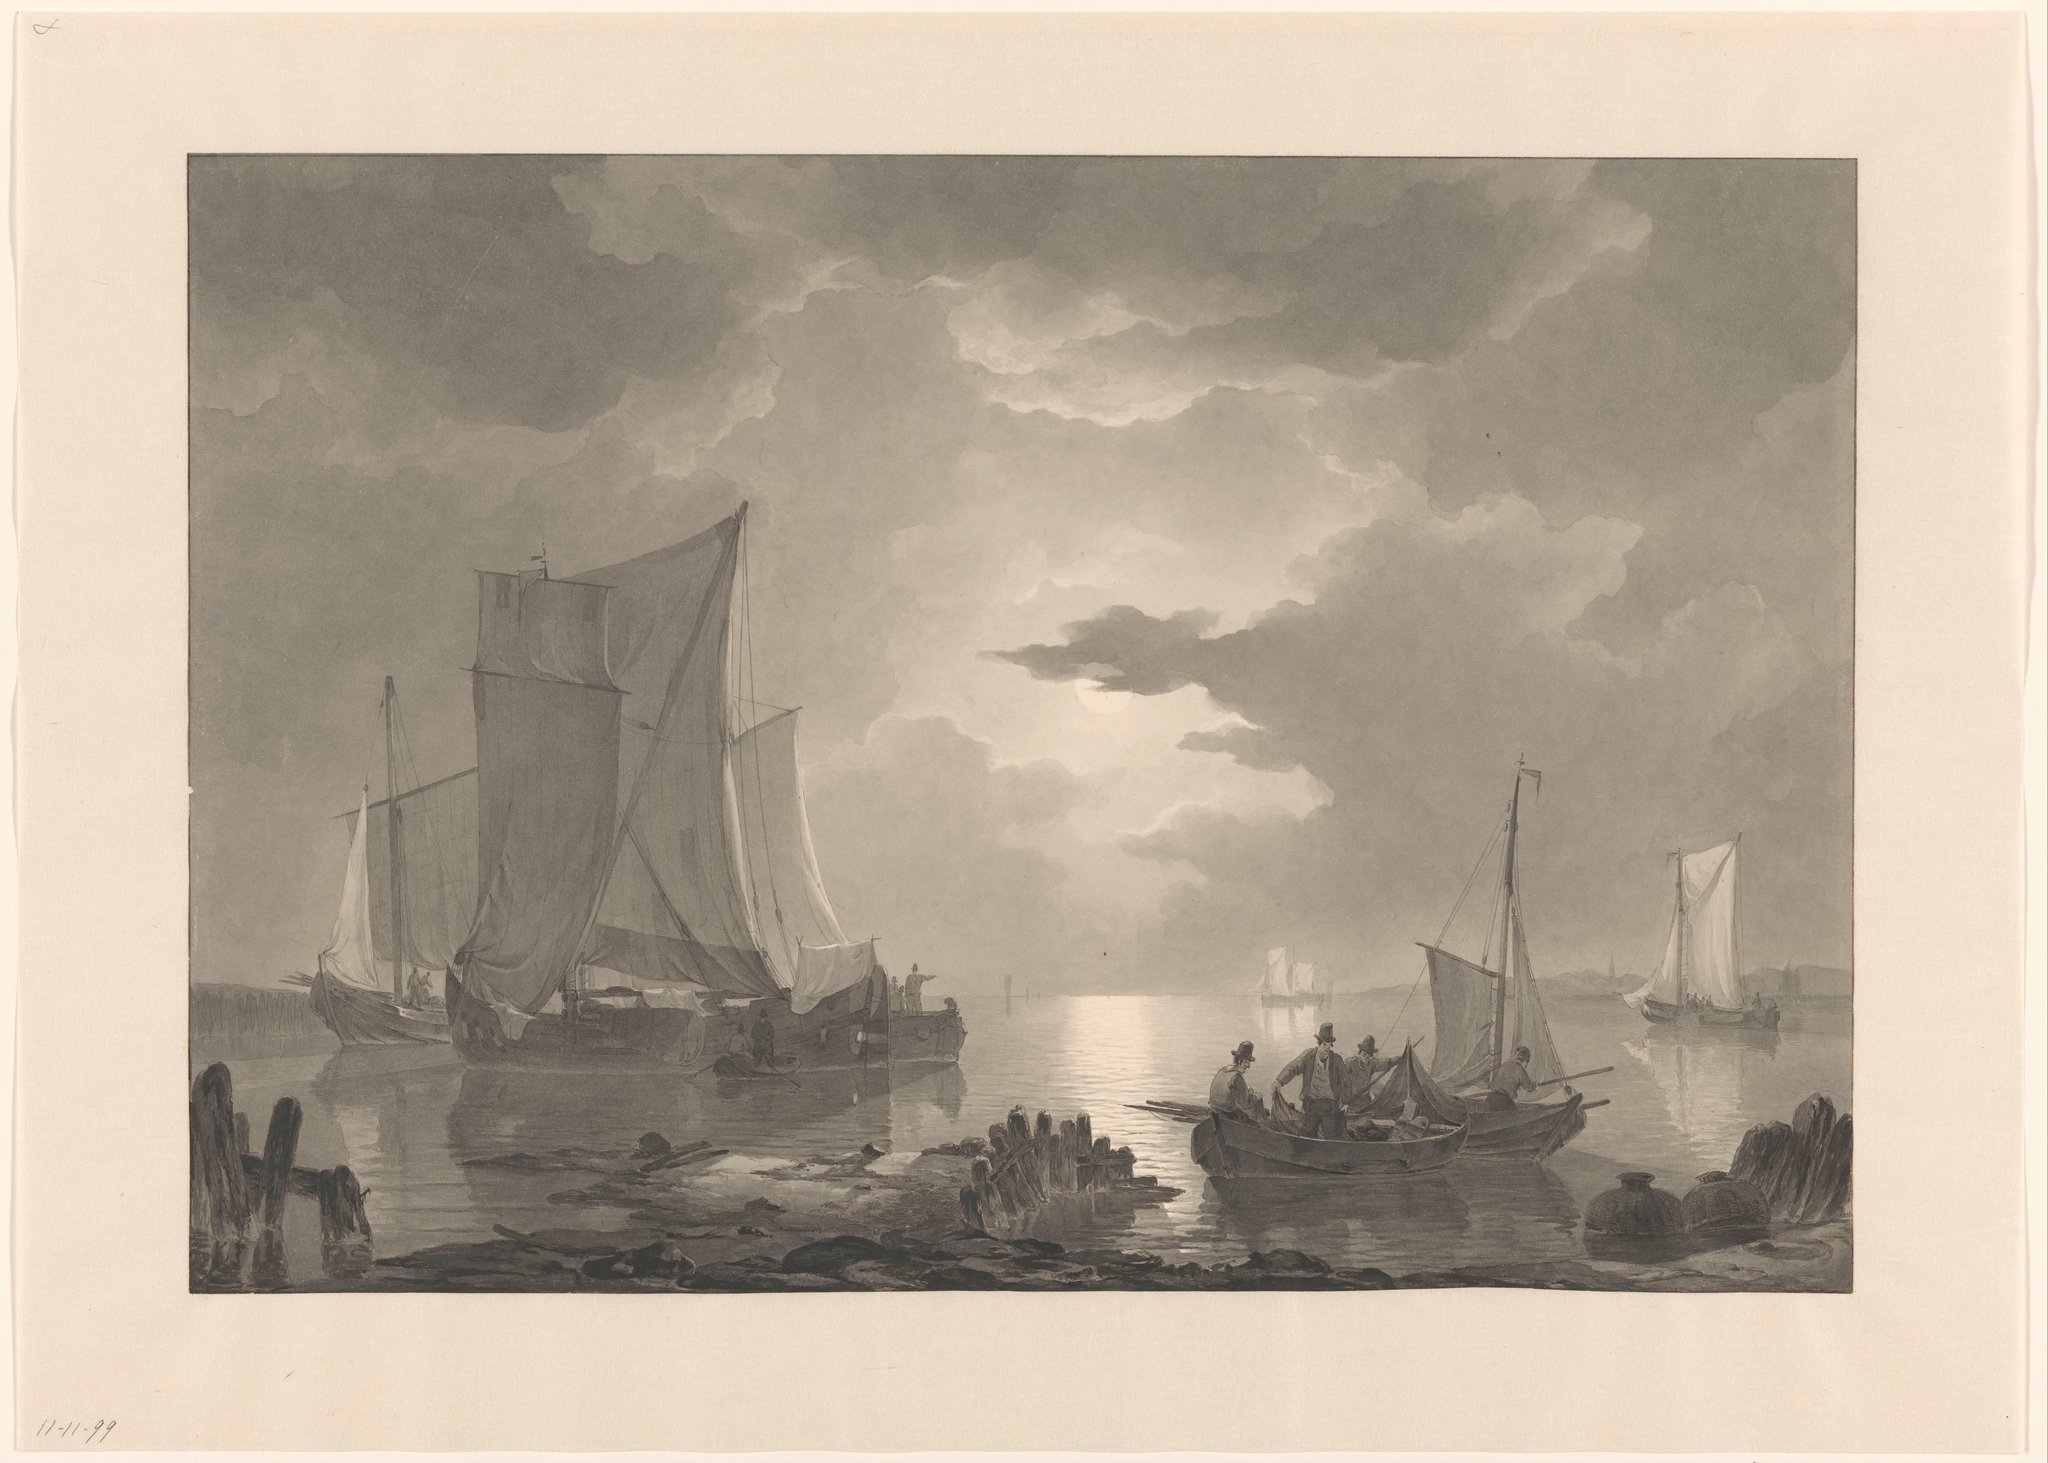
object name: drawing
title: Zeilschepen voor de kust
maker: petrus johannes schotel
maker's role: draughtsman, painter, print maker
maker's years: 1808-1865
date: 1818-1865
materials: ink, paper, pencil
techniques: brush, pen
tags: sailing-ship, sailing-boat, sea (seascape)